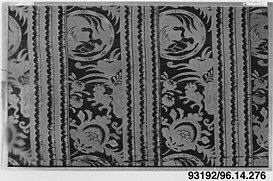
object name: piece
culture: japanese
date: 1701-1900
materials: silk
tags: flowers